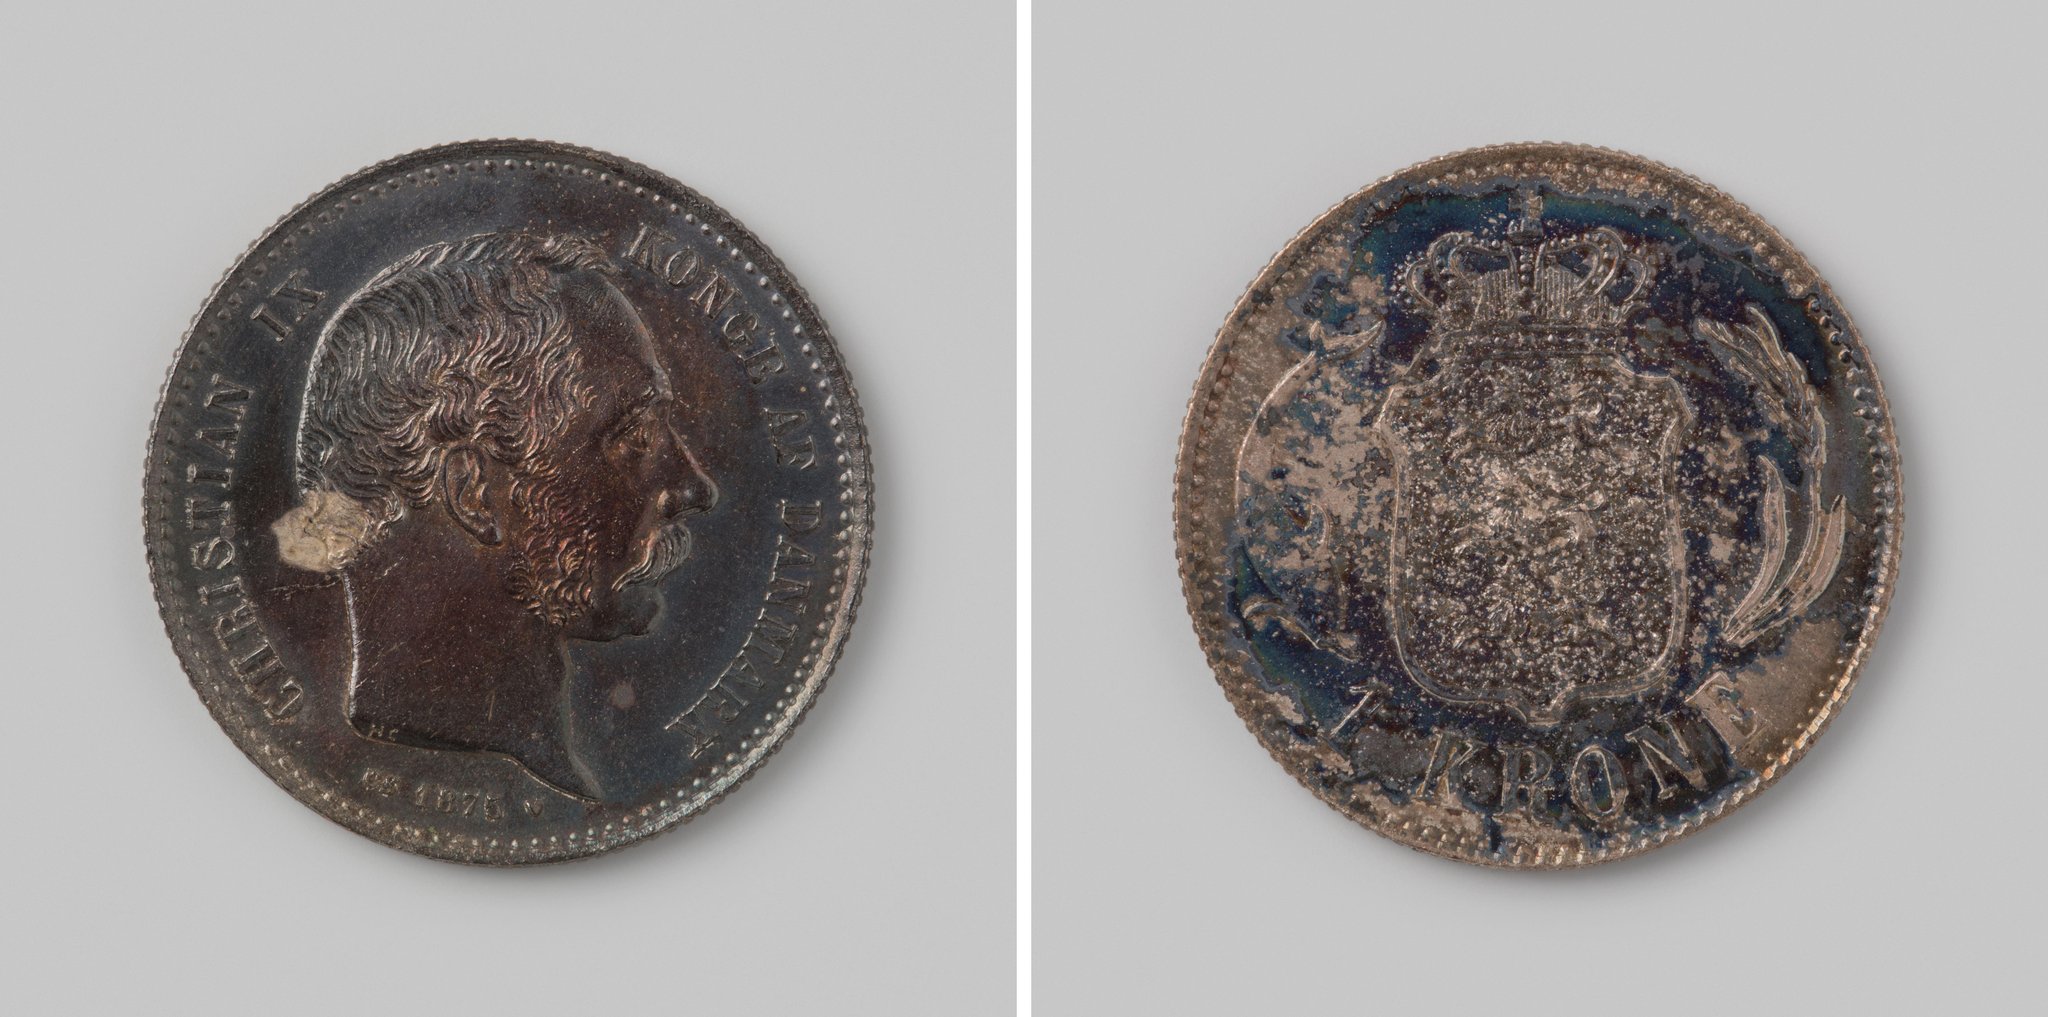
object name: coin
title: Denemarken, Christiaan IX, krone, 1875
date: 1875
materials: silver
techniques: striking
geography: copenhagen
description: Zilveren munt. Voorzijde: hoofd van de koning naar rechts. Daaronder jaartal. Keerzijde: tussen dolfijn en tak gekroond wapenschild. Waarde-aanduiding onderaan als omschrift. Kartelrand.